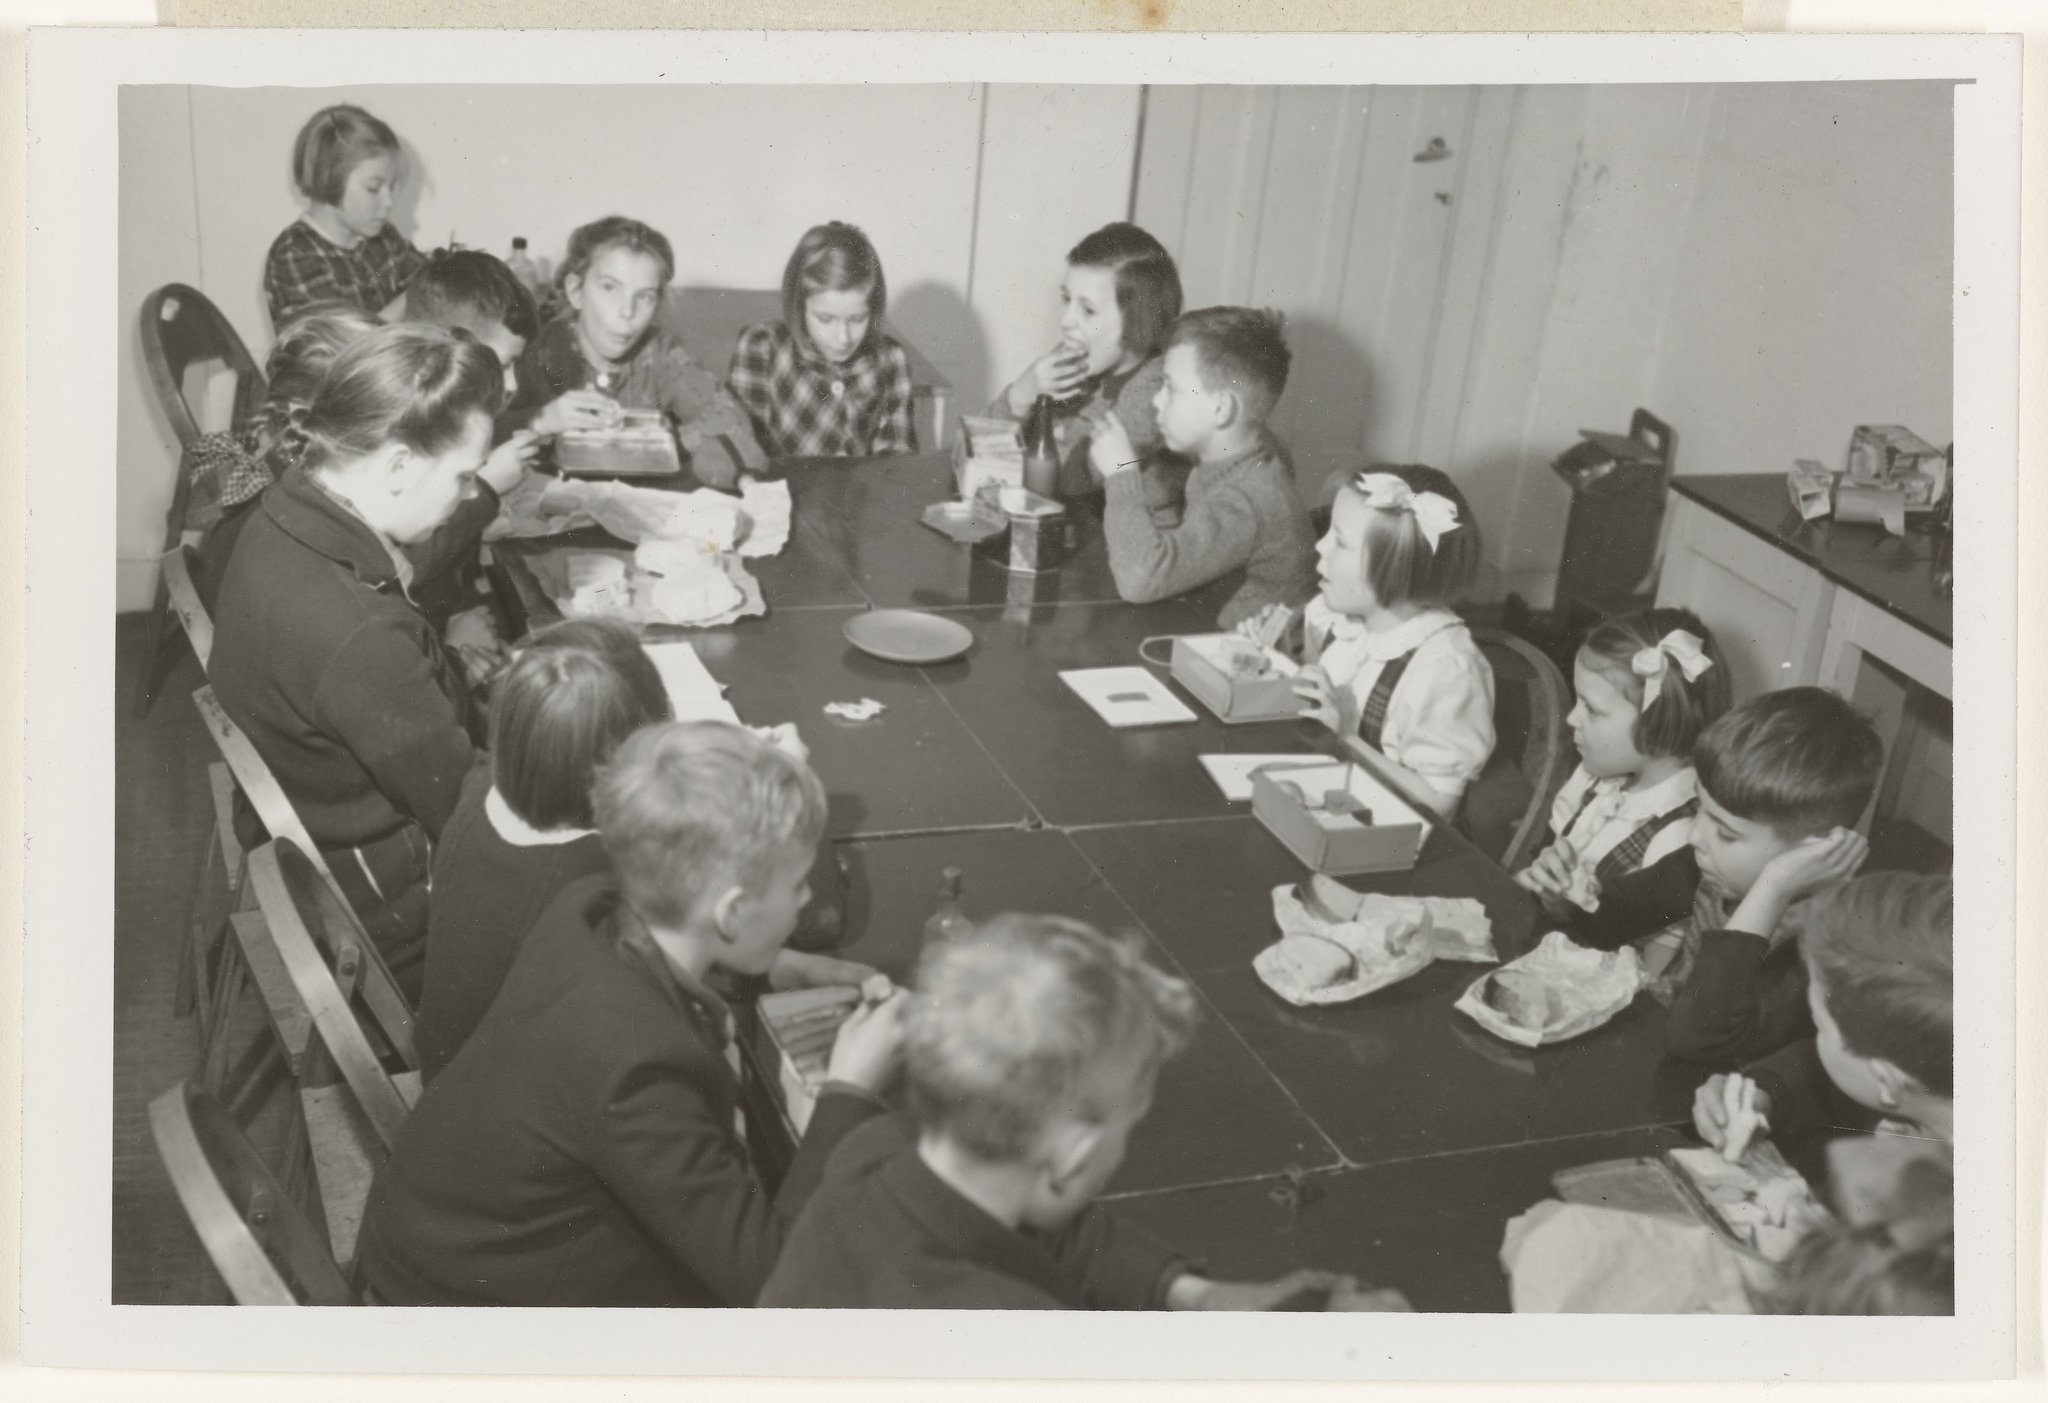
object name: photograph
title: Leerlingen van de Werkplaats Kindergemeenschap Bilthoven tijdens de lunch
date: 1946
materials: photographic support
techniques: photography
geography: bilthoven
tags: beatrix (koningin der nederlanden)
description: Leerlingen van de Werkplaats Kindergemeenschap Bilthoven, ook genoemd de Werkplaats Kees Boeke tijdens de lunch. Onder hen de prinsesjes Beatrix en Irene. Op deze school bleven de leerlingen tussen de middag over op school.